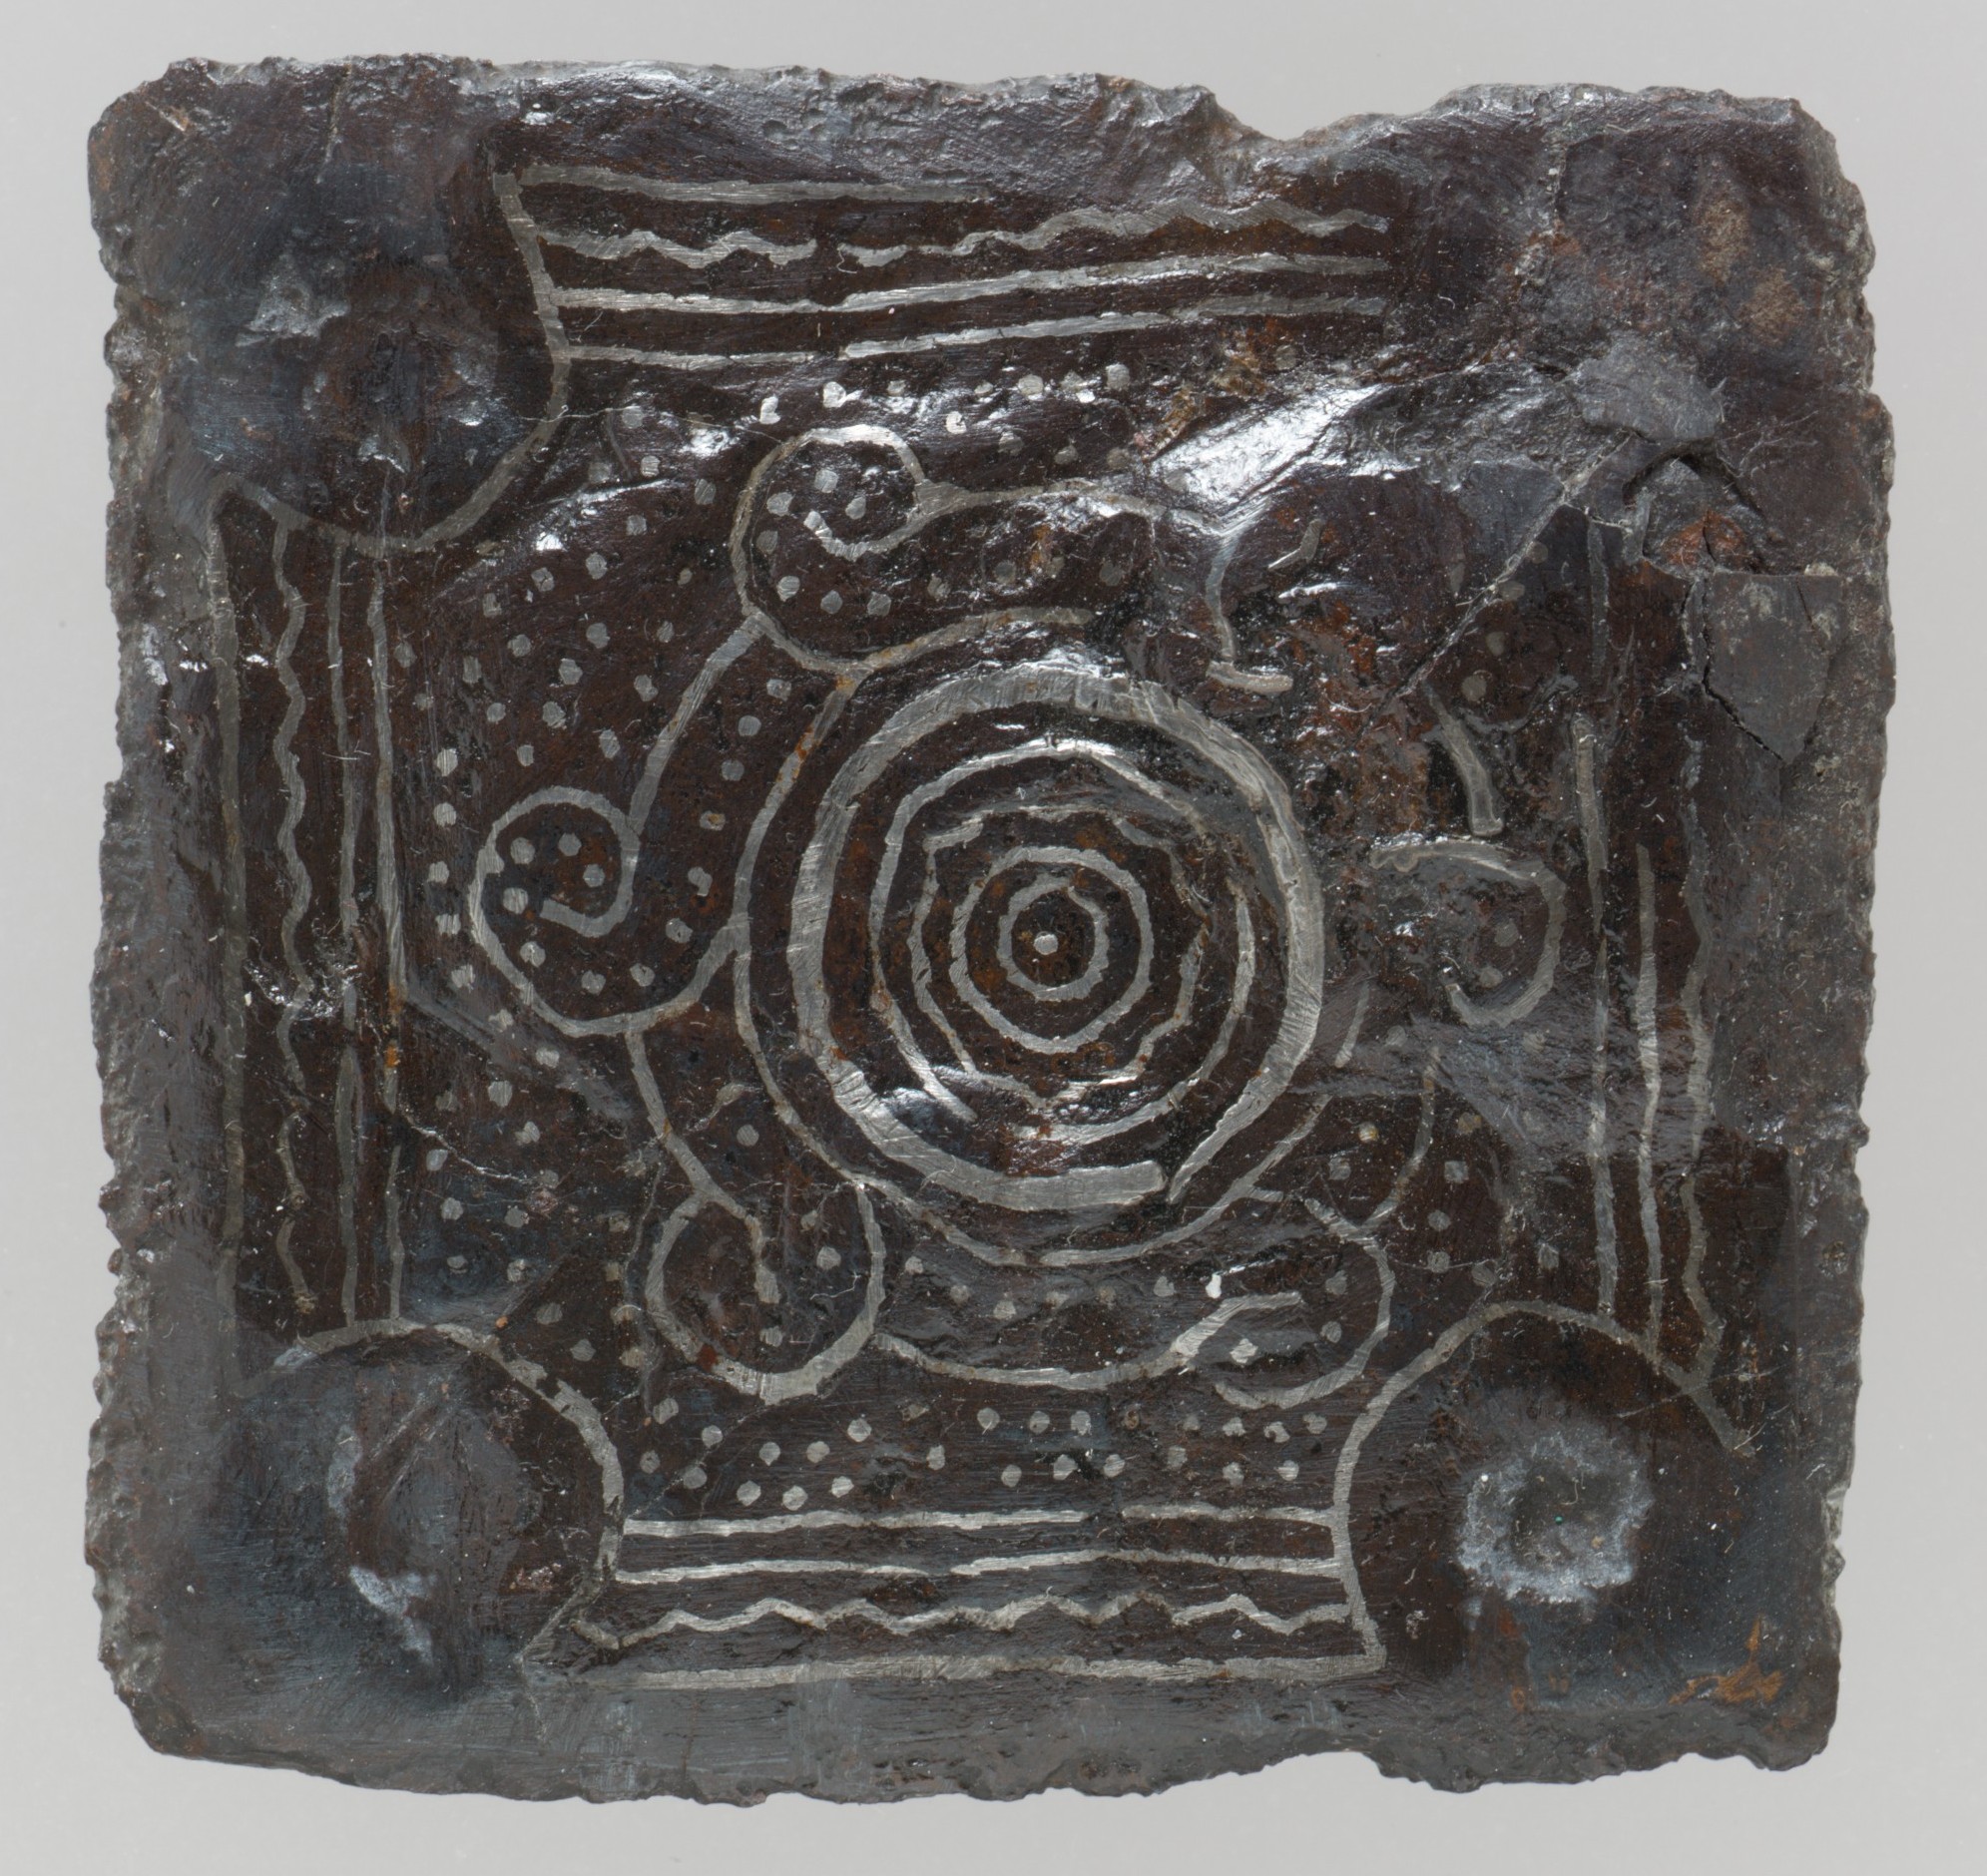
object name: belt plate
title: Back Plate of a Belt Buckle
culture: frankish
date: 567-700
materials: iron, silver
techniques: inlay